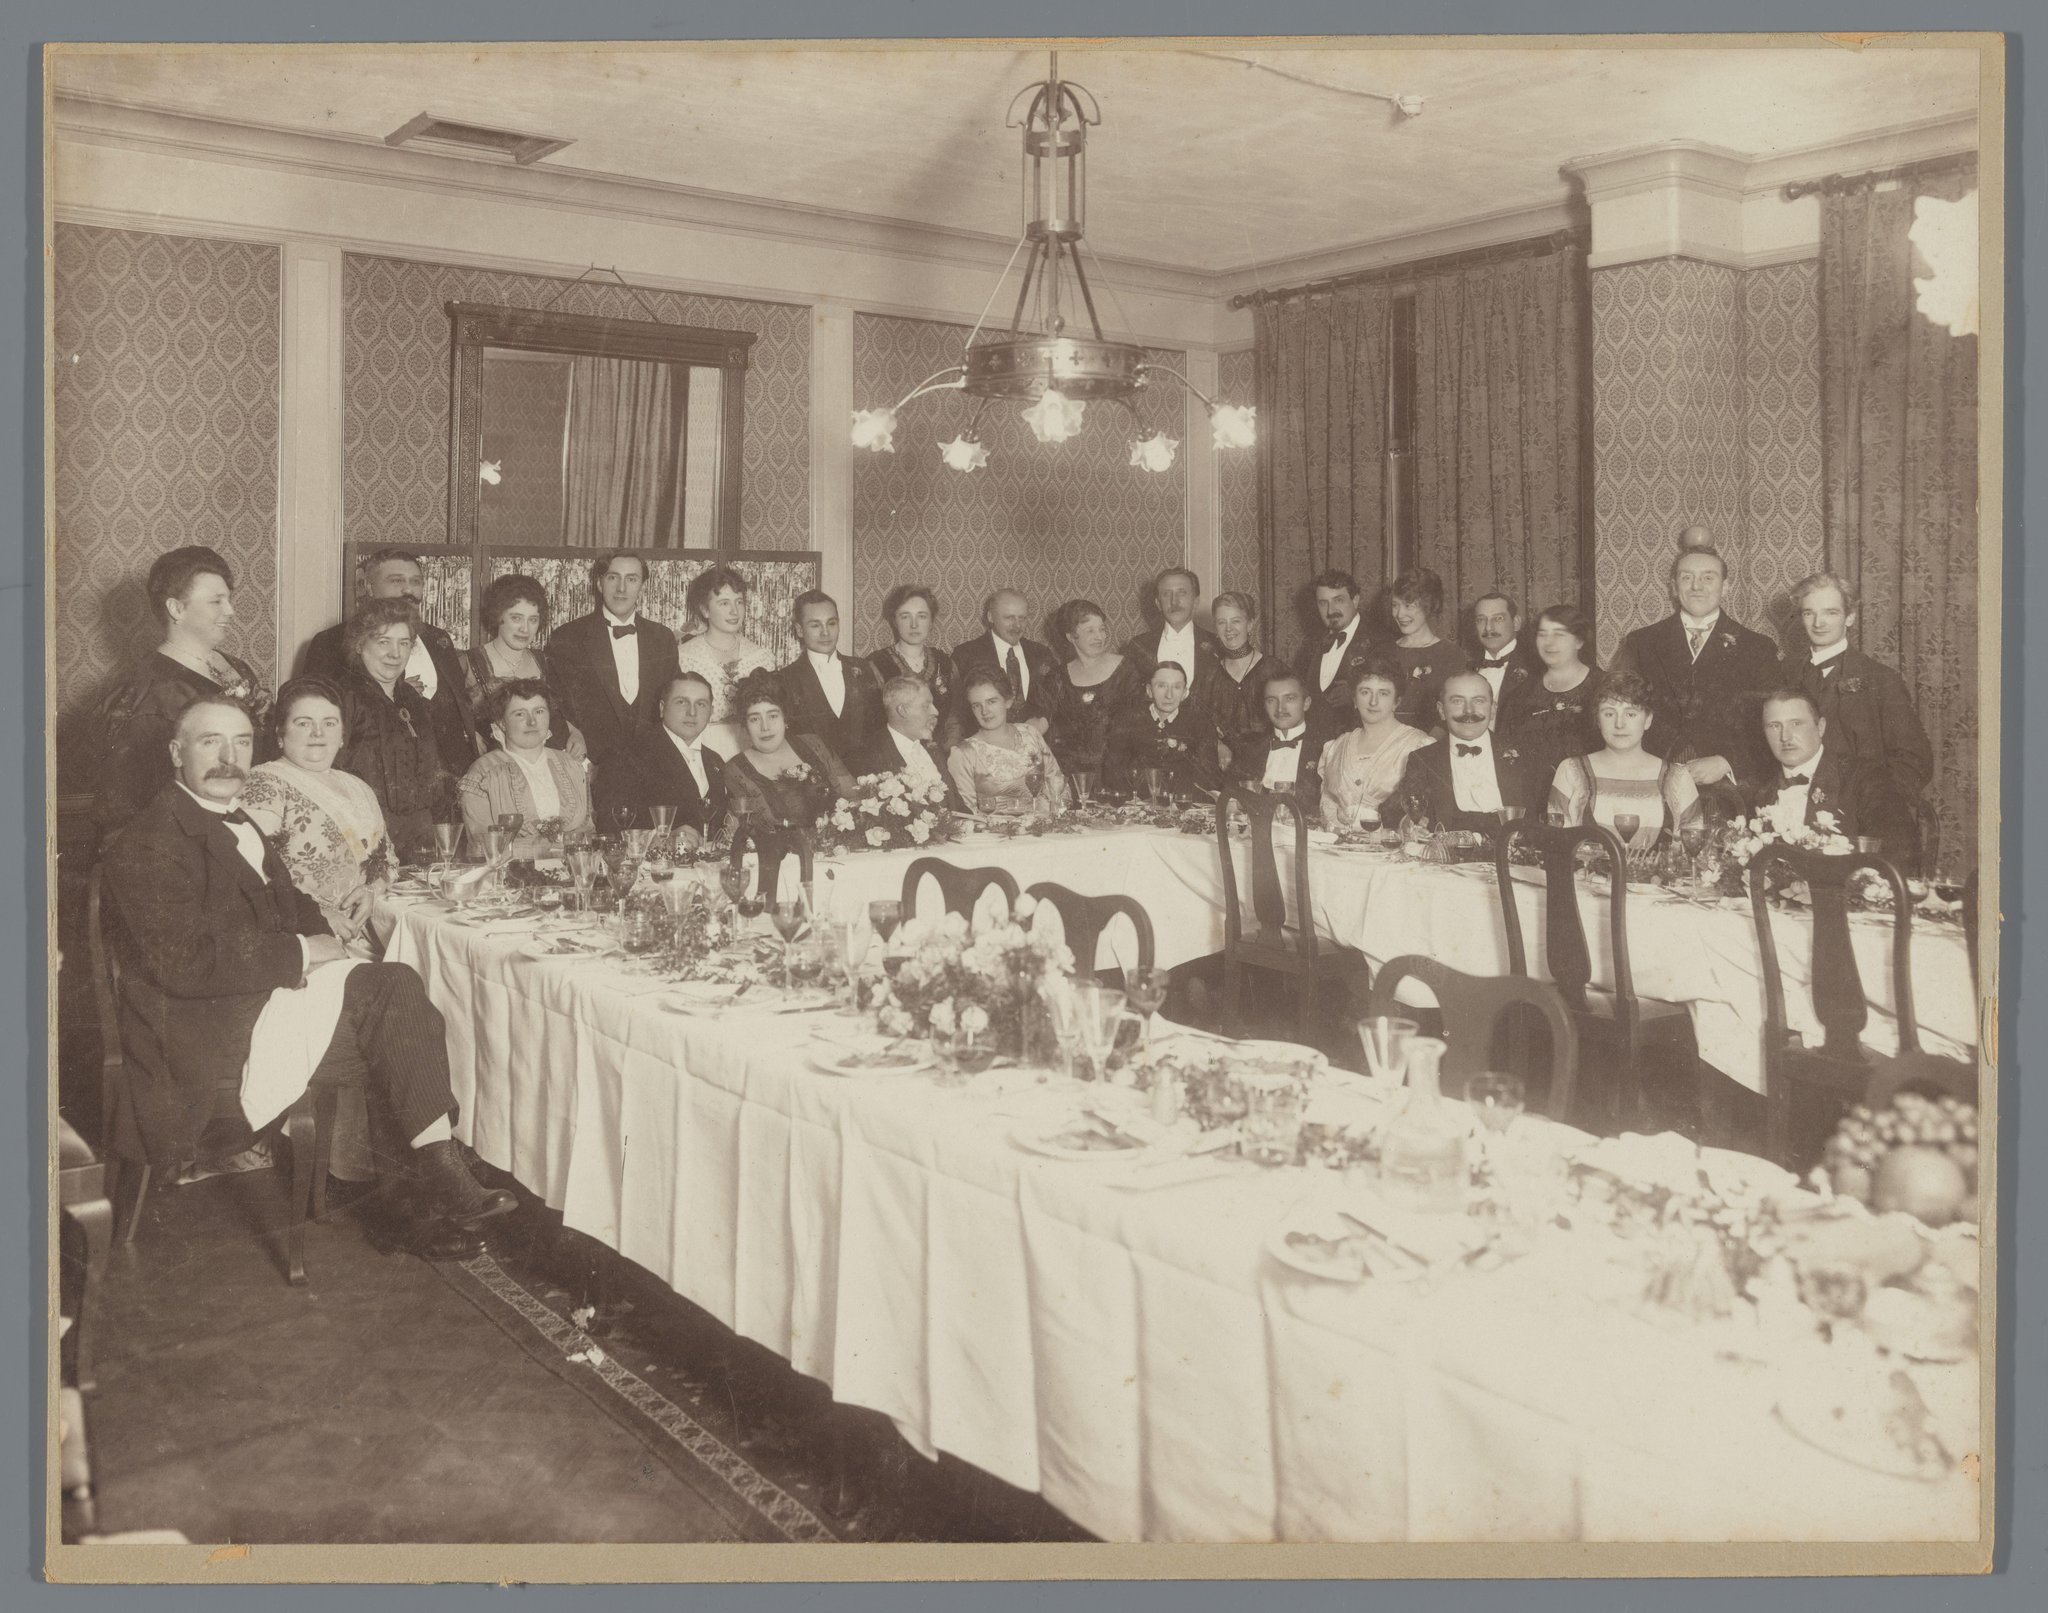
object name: photograph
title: Groepsportret tijdens een diner met George Hendrik Breitner en anderen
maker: Anonymous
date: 1910-1923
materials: paper, cardboard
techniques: gelatin silver print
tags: rotterdam, amsterdam, painter, print maker, draughtsman, george hendrik breitner, evening meal, dinner, supper, anonymous historical persons portrayed in a group, in a group-portrait